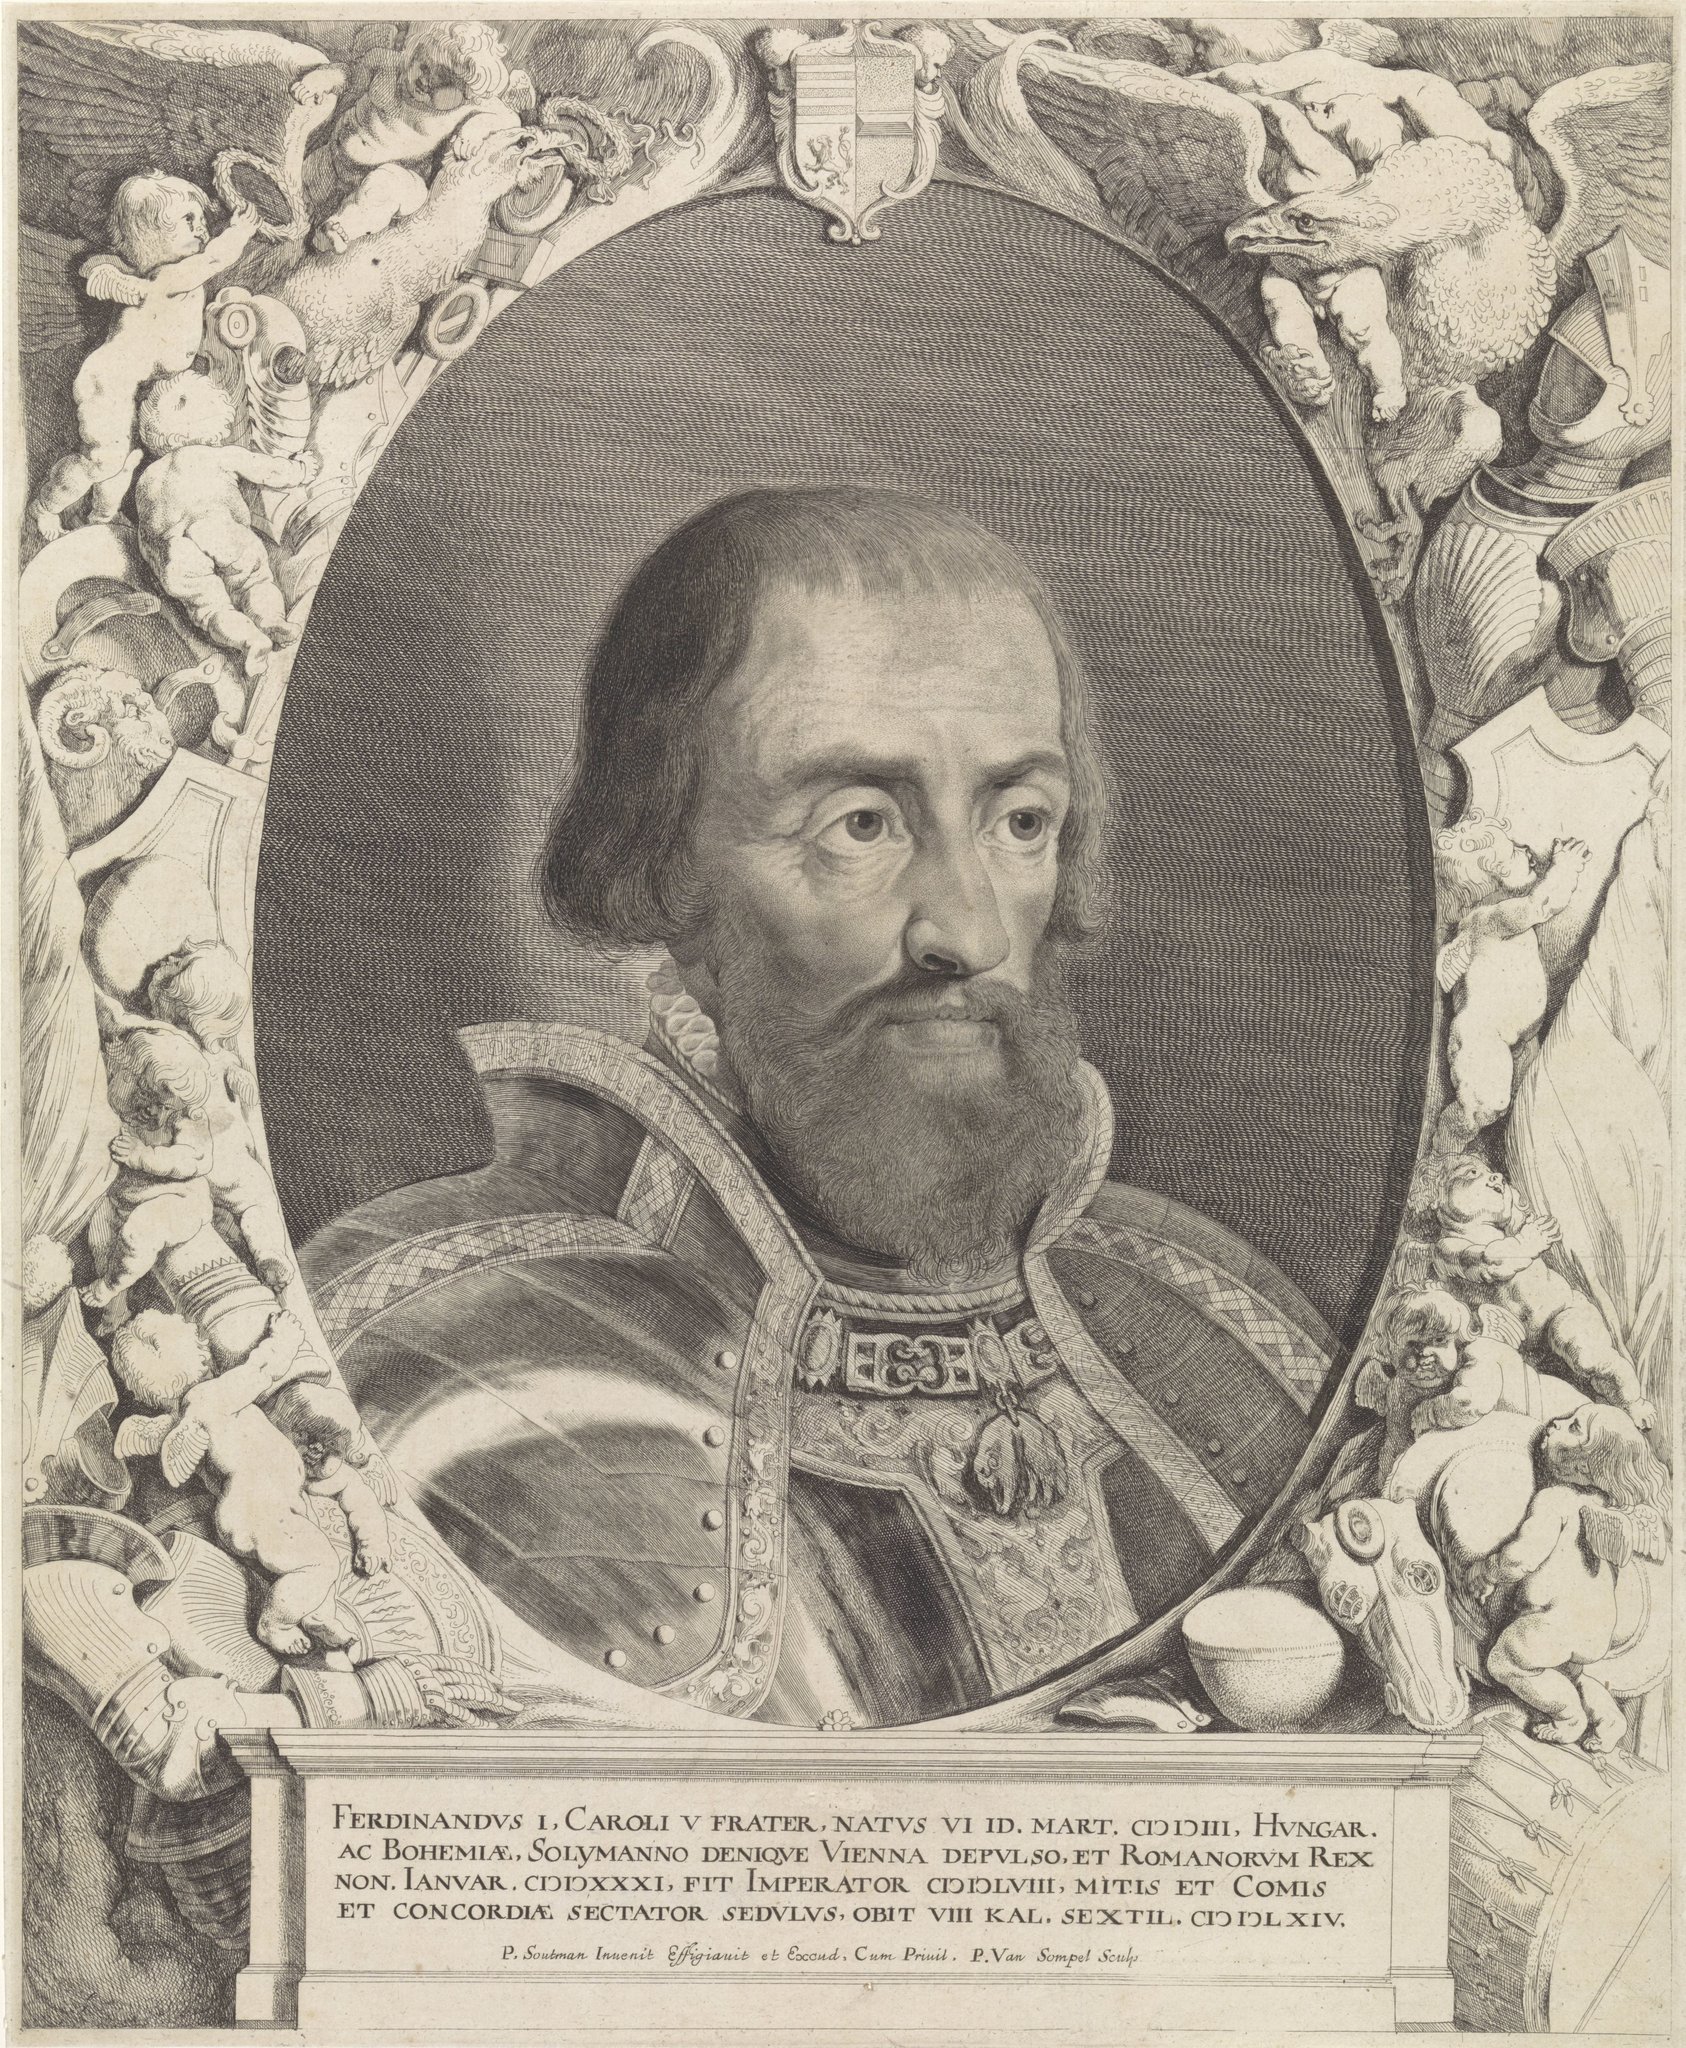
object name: print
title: Portret van keizer Ferdinand I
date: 1680-1750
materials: paper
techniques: engraving, etching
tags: ferdinand i van habsburg (duits keizer), knighthood order of the golden fleece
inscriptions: collector's mark: Lugt 2228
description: Portret van Ferdinand I van Habsburg (Duits keizer). Hij draagt een keten met de versierselen van de Orde van het Gulden Vlies. Het portret wordt omlijst door een randversiering met putti en harnasonderdelen. In de beide bovenhoeken een adelaar, in het midden zijn wapenschild. Onder het portret een cartouche met in het Latijn zijn naam, titels en een korte levensbeschrijving.